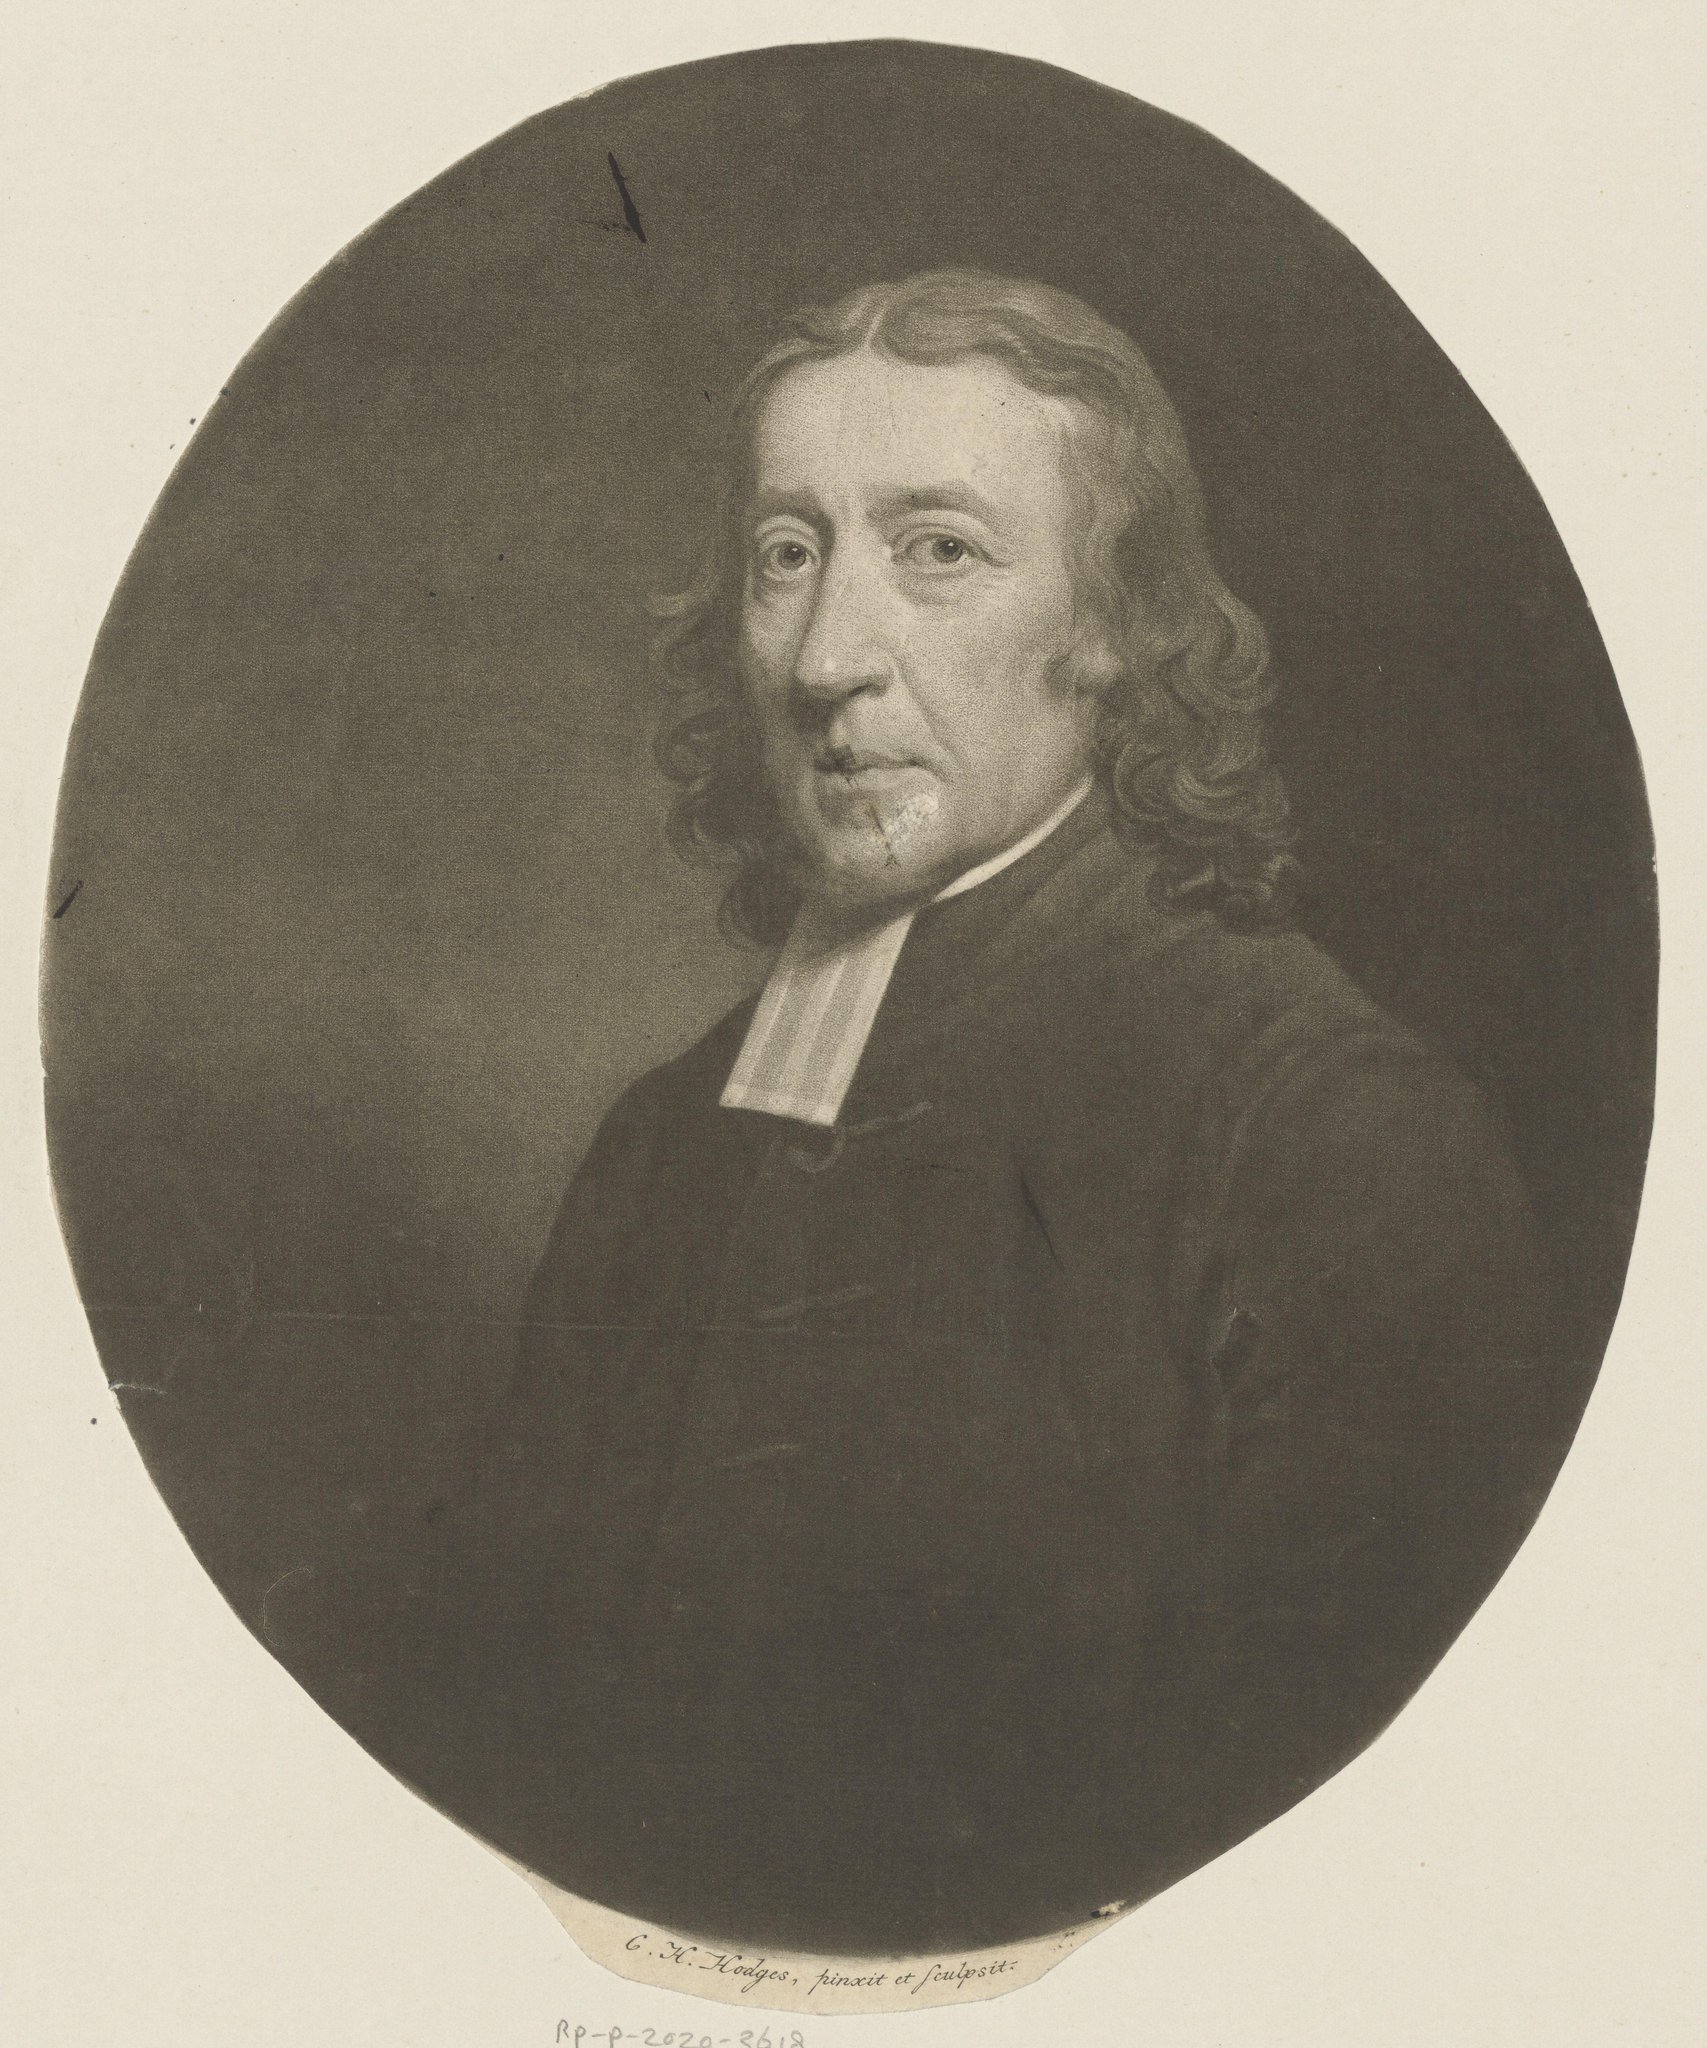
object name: print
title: Portret van Bartout van der Feen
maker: charles howard hodges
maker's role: draughtsman, painter, print maker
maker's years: 1764-1837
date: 1806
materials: paper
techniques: mezzotint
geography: amsterdam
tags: historical persons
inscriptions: inscription: ‘D. van der Feen/ van Amsterdam/ door/ C.H. Hodges’